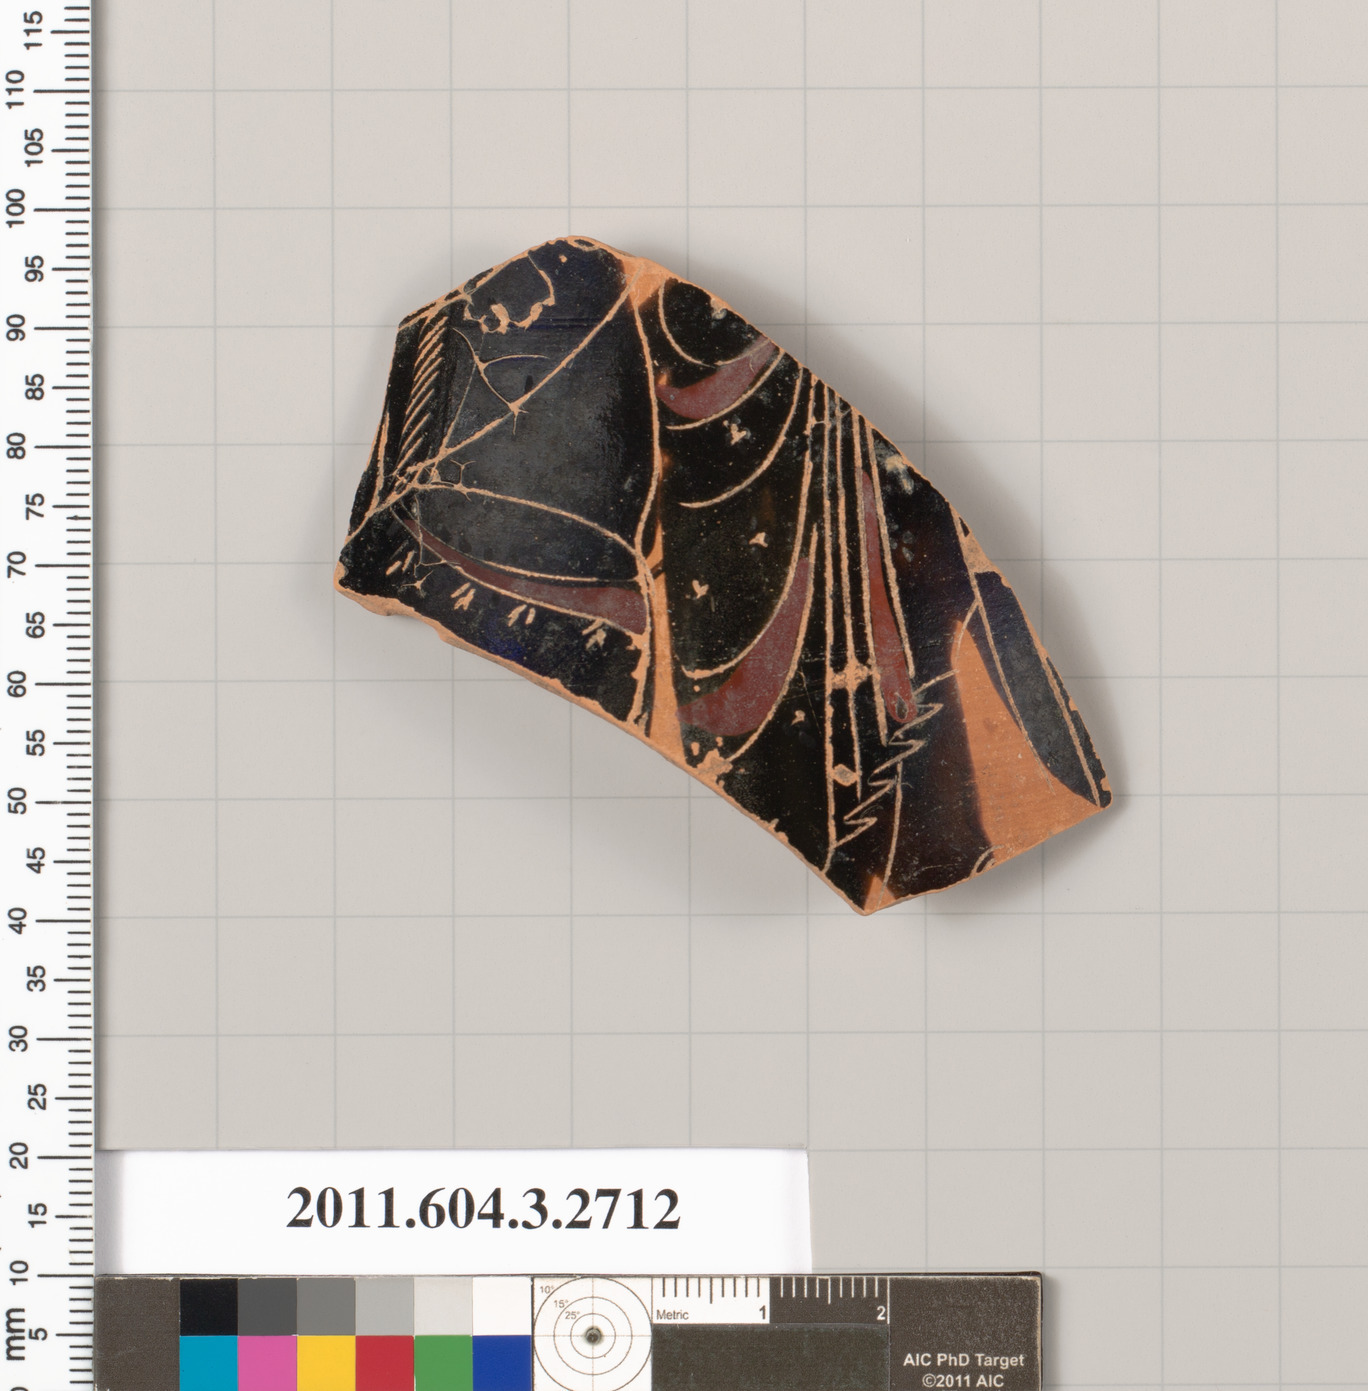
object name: olpe fragment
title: Terracotta fragment of an olpe (jug)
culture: greek, attic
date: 520-500 BCE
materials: terracotta